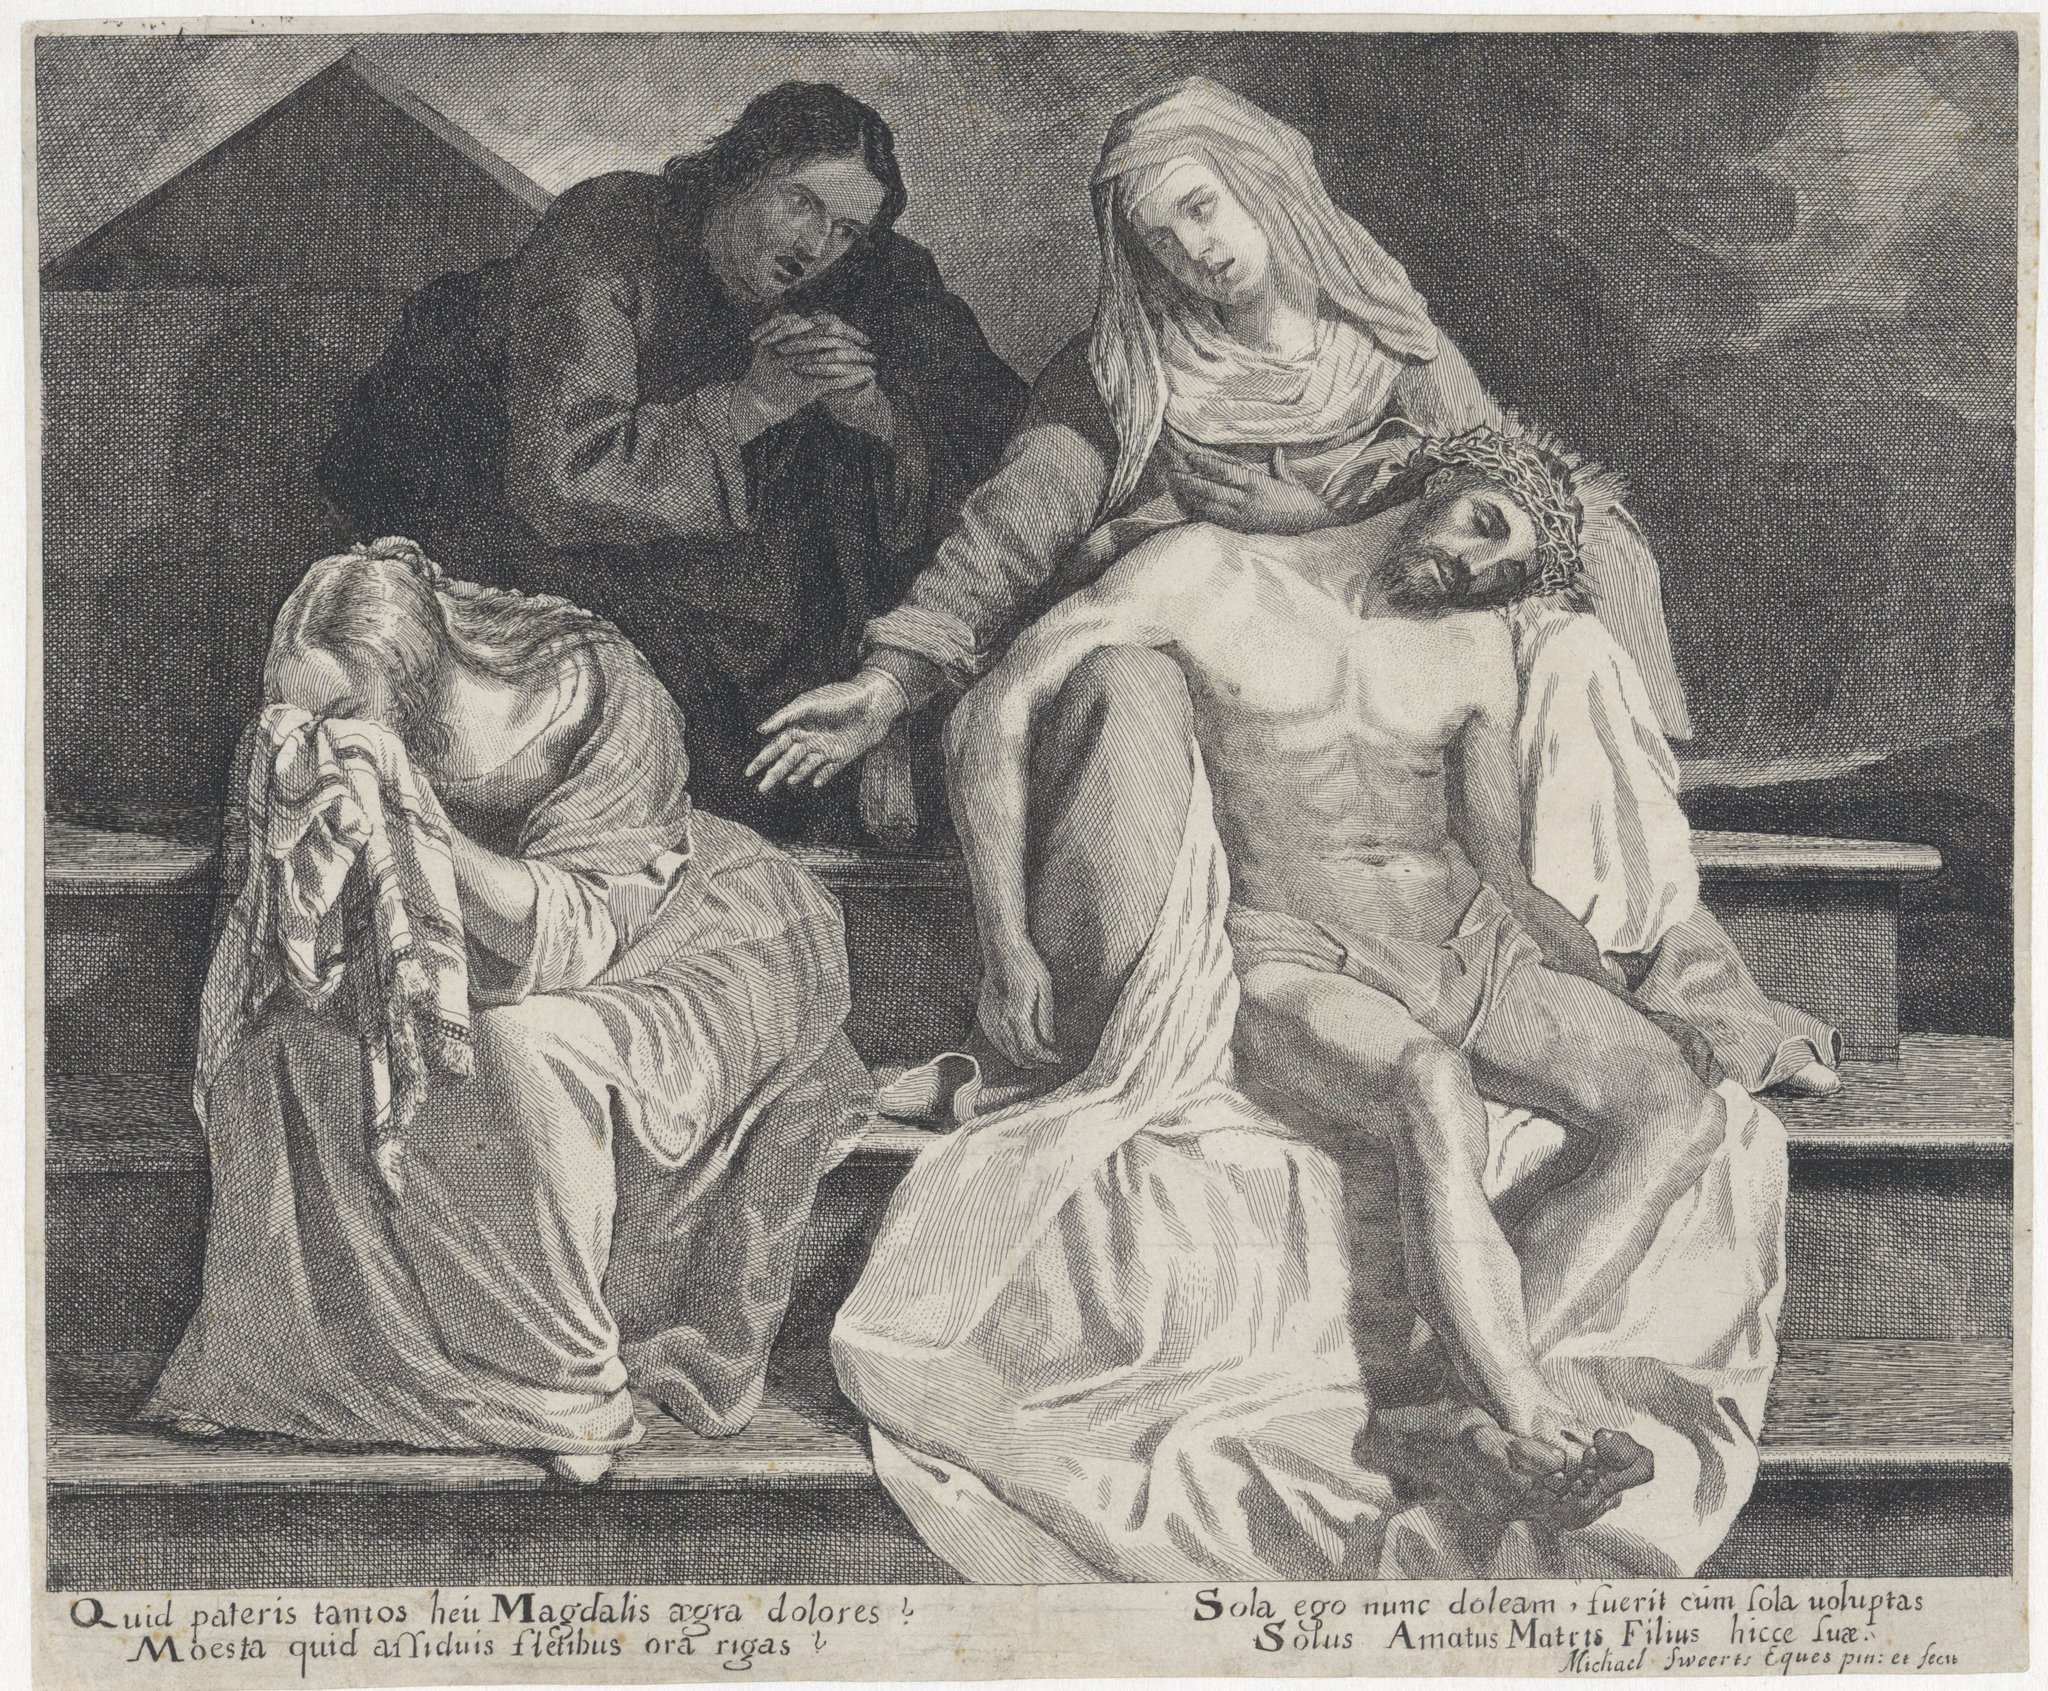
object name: print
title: Bewening van Christus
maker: michael sweerts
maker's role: painter, print maker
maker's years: 1618-1664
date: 1643-1661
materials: paper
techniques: engraving, etching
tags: christ's body supported by mary, others present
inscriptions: collector's mark: Lugt 2228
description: Het dode lichaam van Christus rust in de schoot van Maria, op de trappen van het graf. Naast haar de wenende Maria Magdalena en achter haar Johannes in biddende houding. Onder de afbeelding vier versregels in het Latijn.